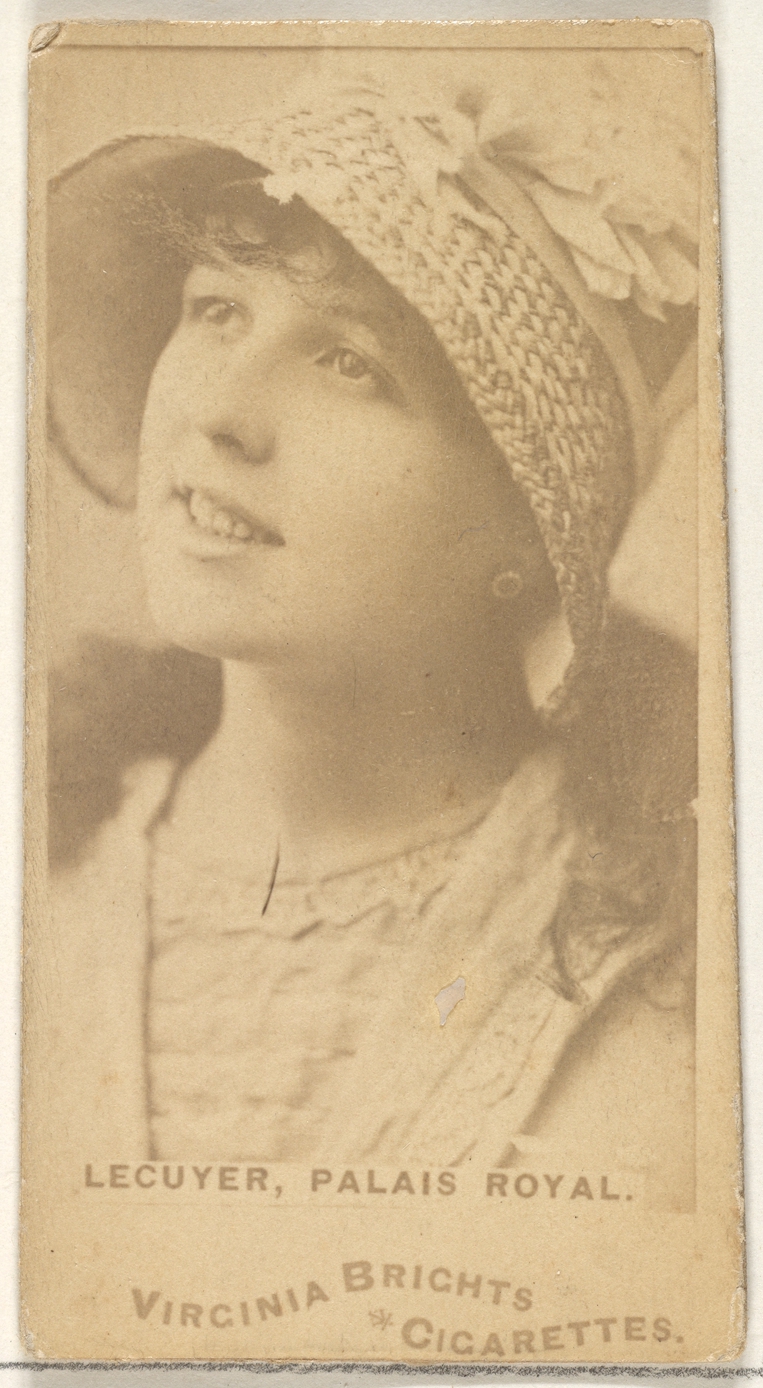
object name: photograph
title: Lecuyer, Palais Royal, from the Actors and Actresses series (N45, Type 1) for Virginia Brights Cigarettes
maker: allen & ginter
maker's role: publisher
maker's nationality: american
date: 1888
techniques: albumen silver print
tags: portraits,women,actresses